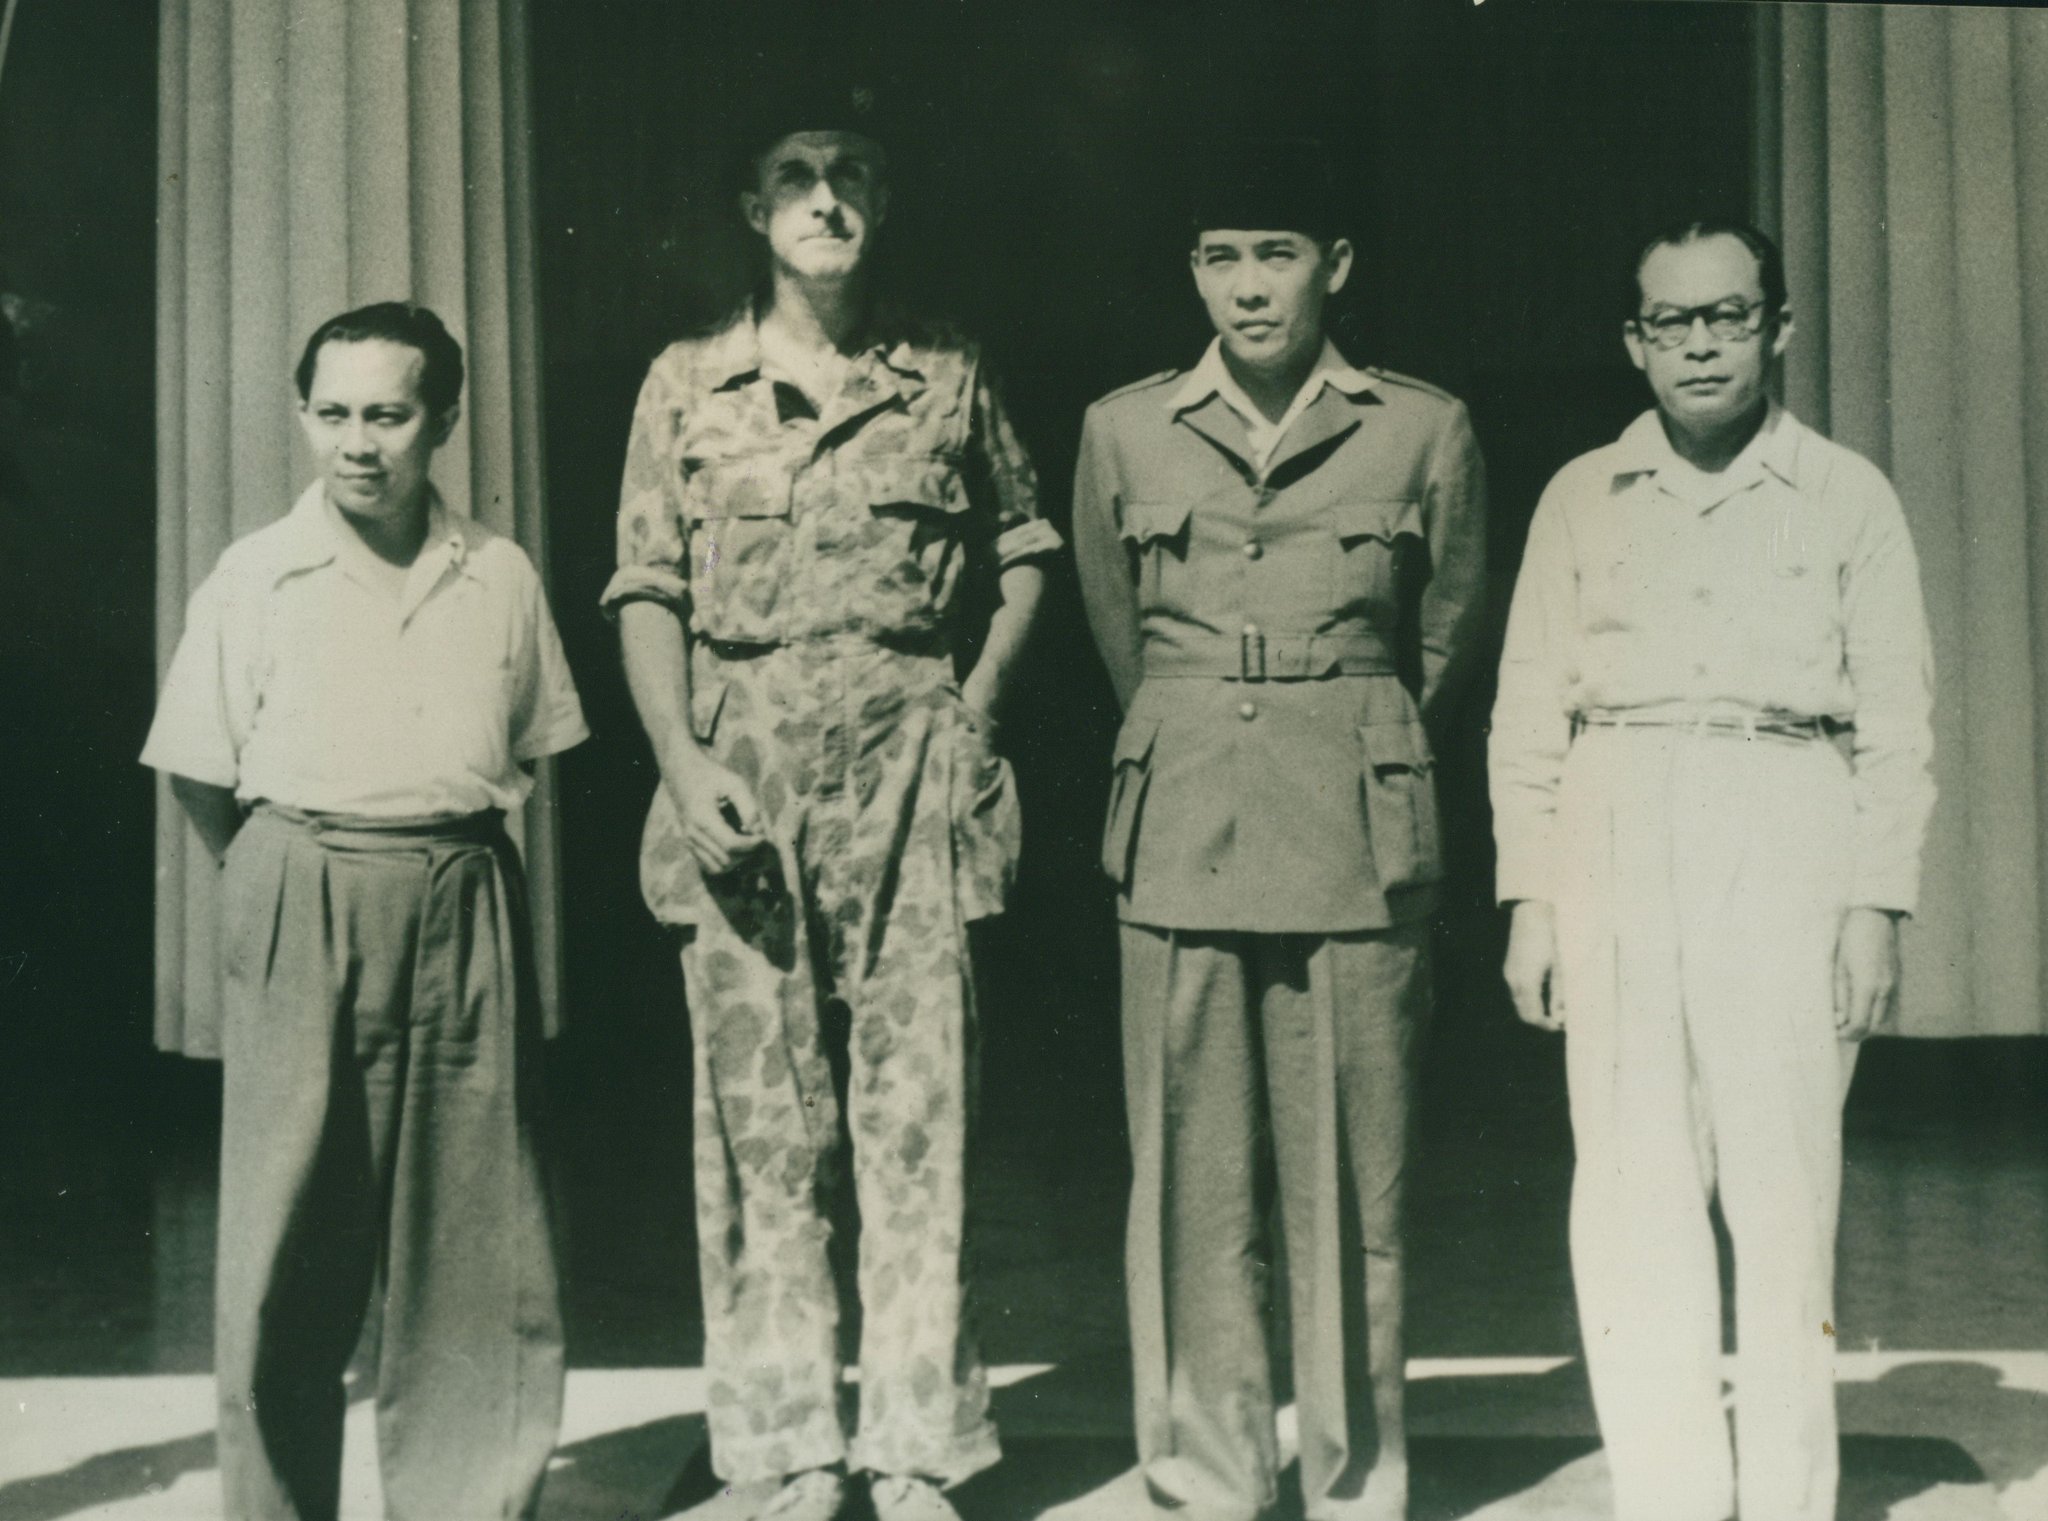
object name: documentary photograph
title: President Soekarno gevangen gehouden in zijn eigen paleis in Jogyakarta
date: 1901-1949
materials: photographic support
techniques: photography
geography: jogjakarta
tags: surabaya, united nations, mohammad hatta, netherlands, indonesia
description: Na de Tweede Politionele Actie namen Nederlandse militairen president Soekarno en andere politieke topstukken gevangen. Op het bordes van het paleis van Soekarno staan van links naar rechts: de voormalige Republikeinse premier Sutan Sjahrir, een Nederlandse militair, president Soekarno en premier Hatta.